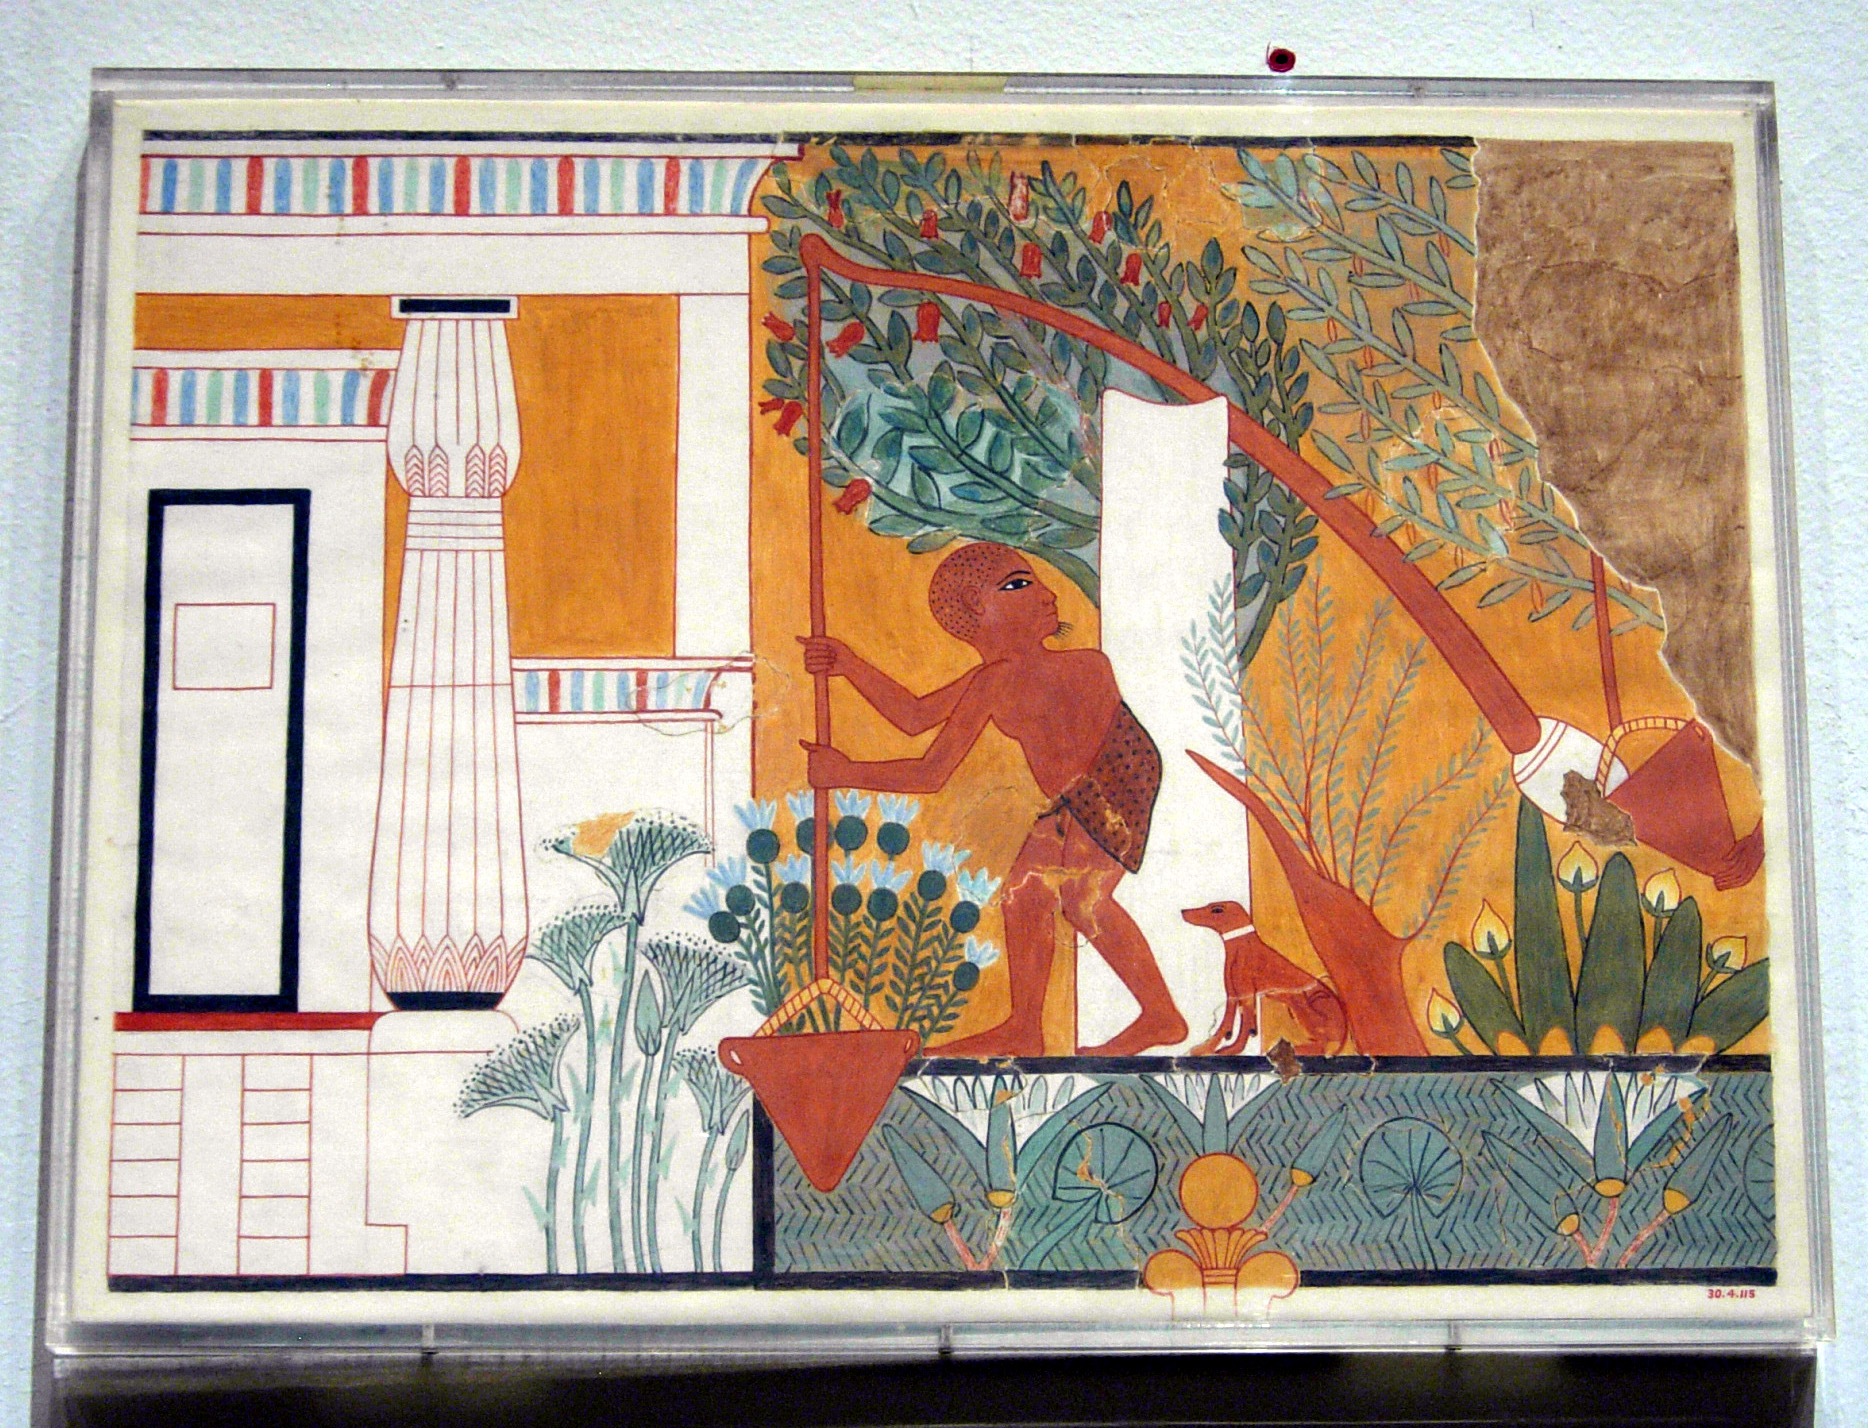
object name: facsimile, ipuy tt 217, garden, house, shadduf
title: Garden Scene, Tomb of Ipuy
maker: norman de garis davies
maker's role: artist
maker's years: 1865-1941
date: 1295-1213 BCE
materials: paper, paint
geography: egypt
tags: gardens,men